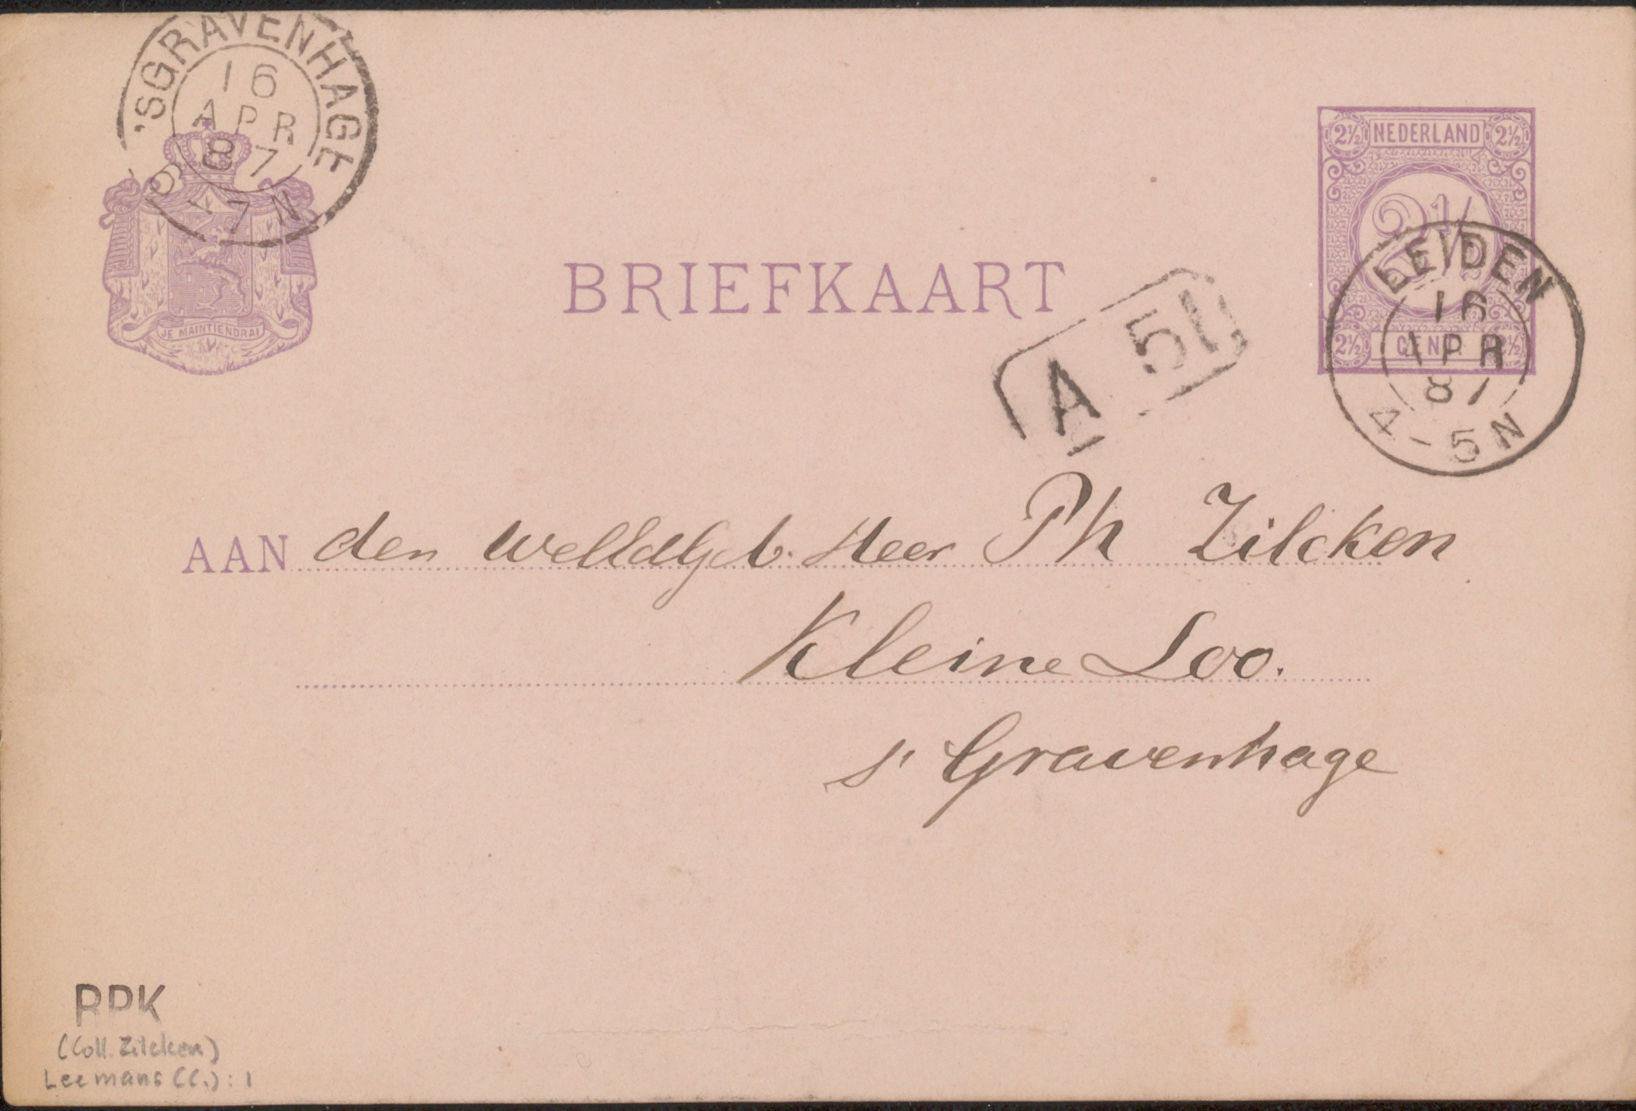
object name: postcard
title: Briefkaart aan Philip Zilcken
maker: conradus leemans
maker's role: hoogleraar, museumdirecteur, oudheidkundige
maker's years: 1809-1893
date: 1887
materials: cardboard, ink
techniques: pen, writing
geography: leiden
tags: utrecht, the hague, painter, draughtsman, philip zilcken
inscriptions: collector's mark: ‘RPK’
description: Brief bevat een aantekening van Philip Zilcken op een los vel papier.